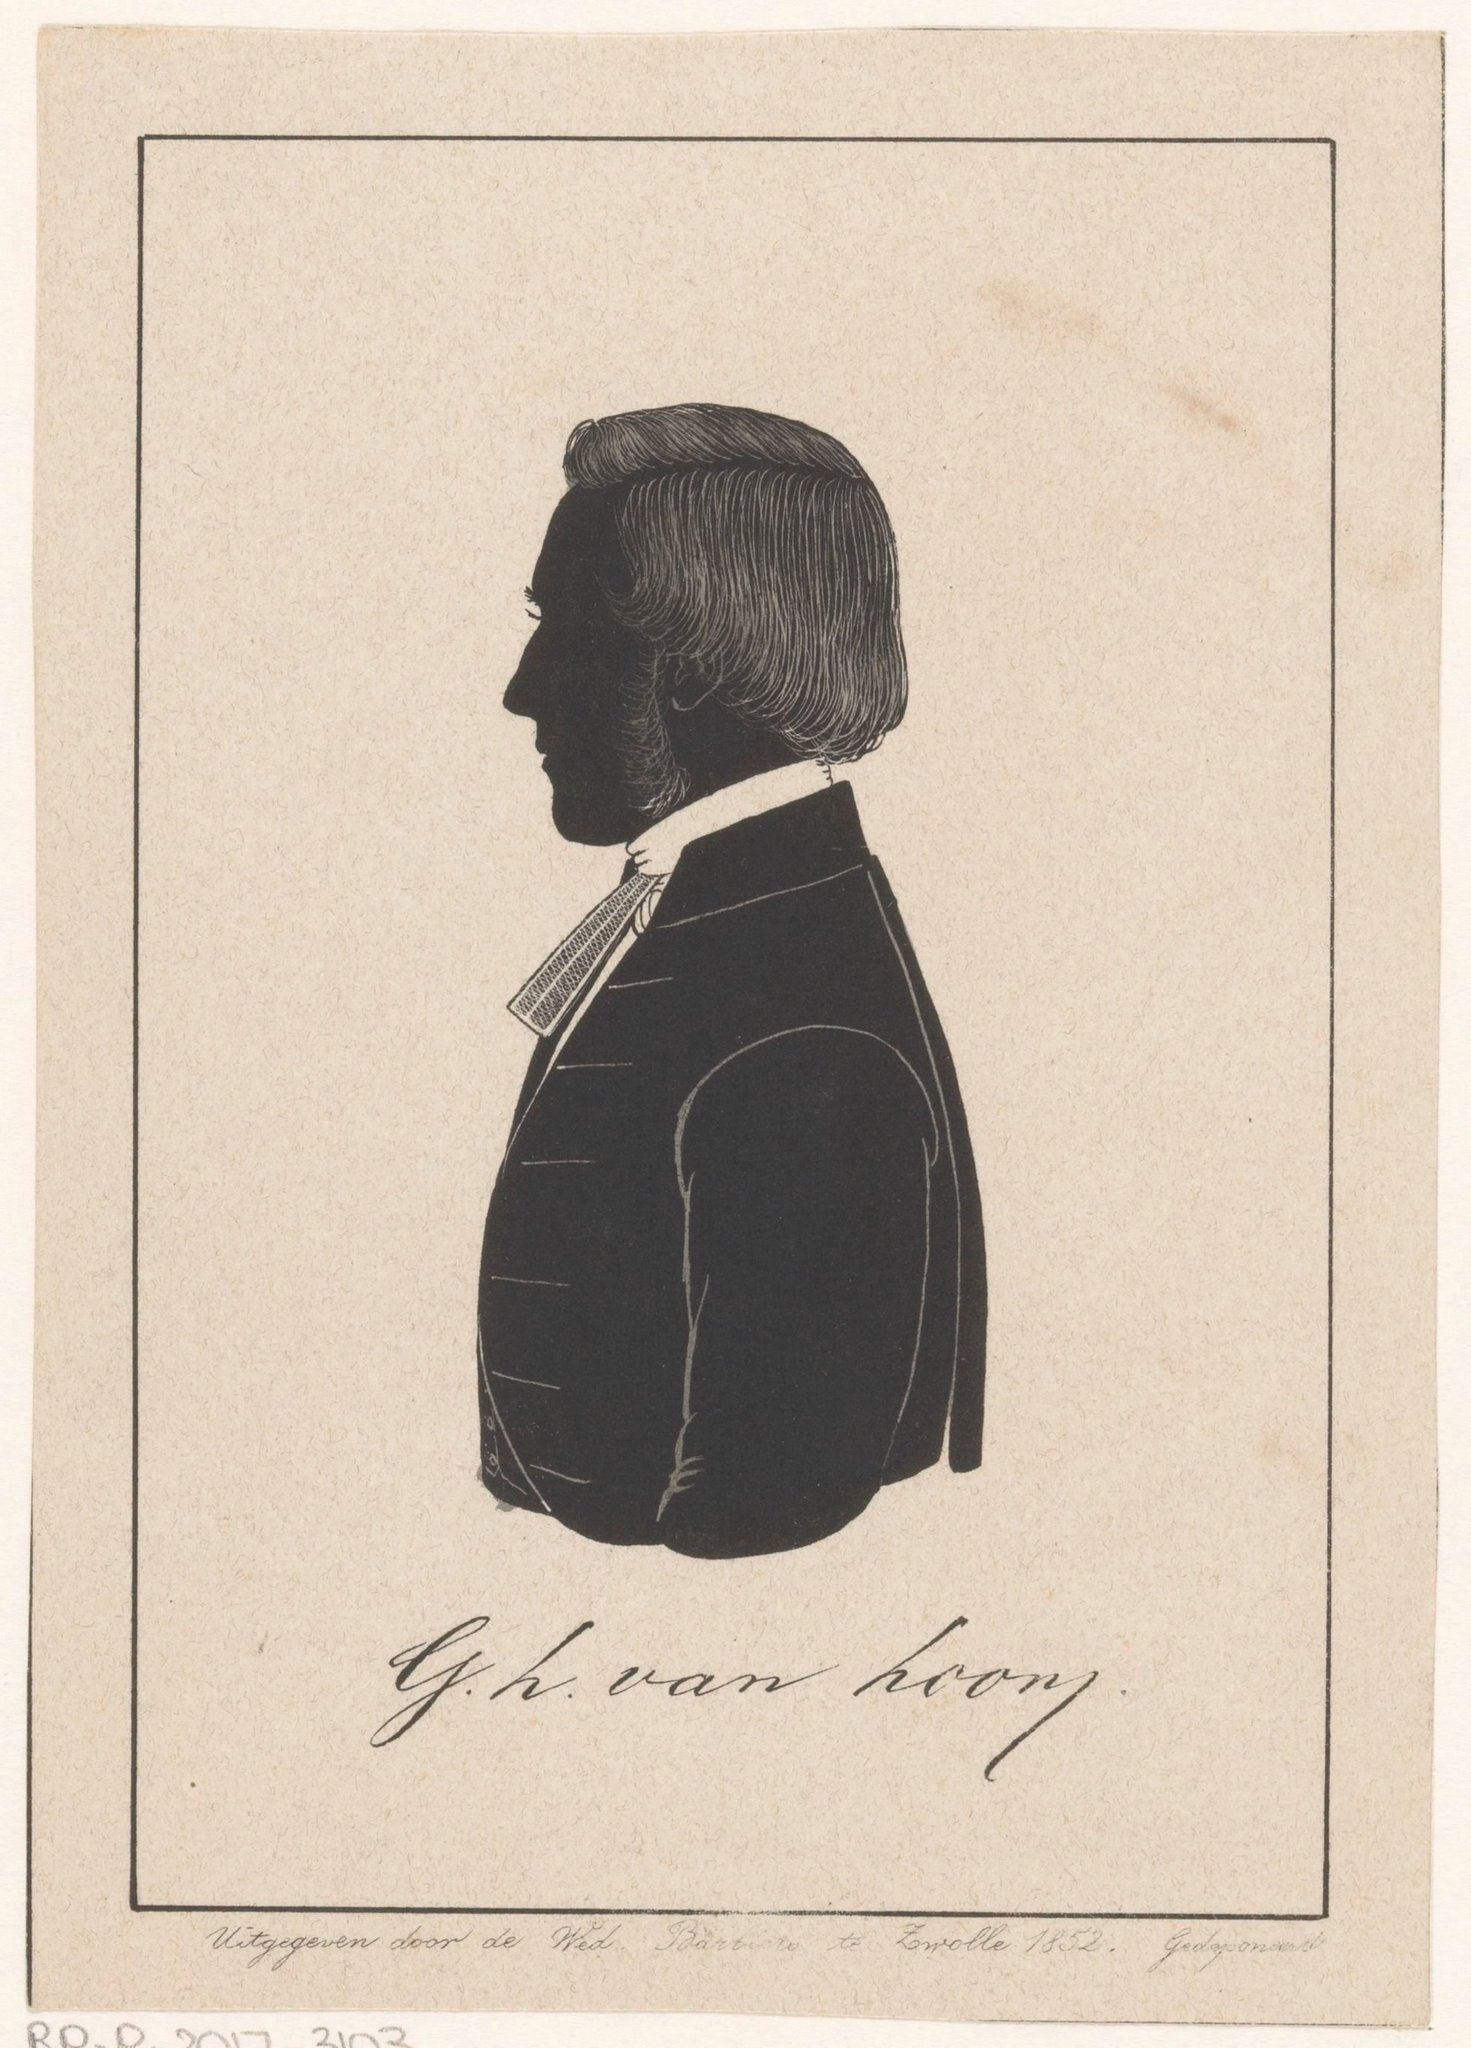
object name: print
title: Silhouetportret van G.H. van Loon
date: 1852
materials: paper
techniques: hand coloring, lithograph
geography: zwolle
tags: historical persons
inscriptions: collector's mark: Lugt 2228, : ‘Gedeponeerd.’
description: Onder het portret de signatuur van de geportretteerde.